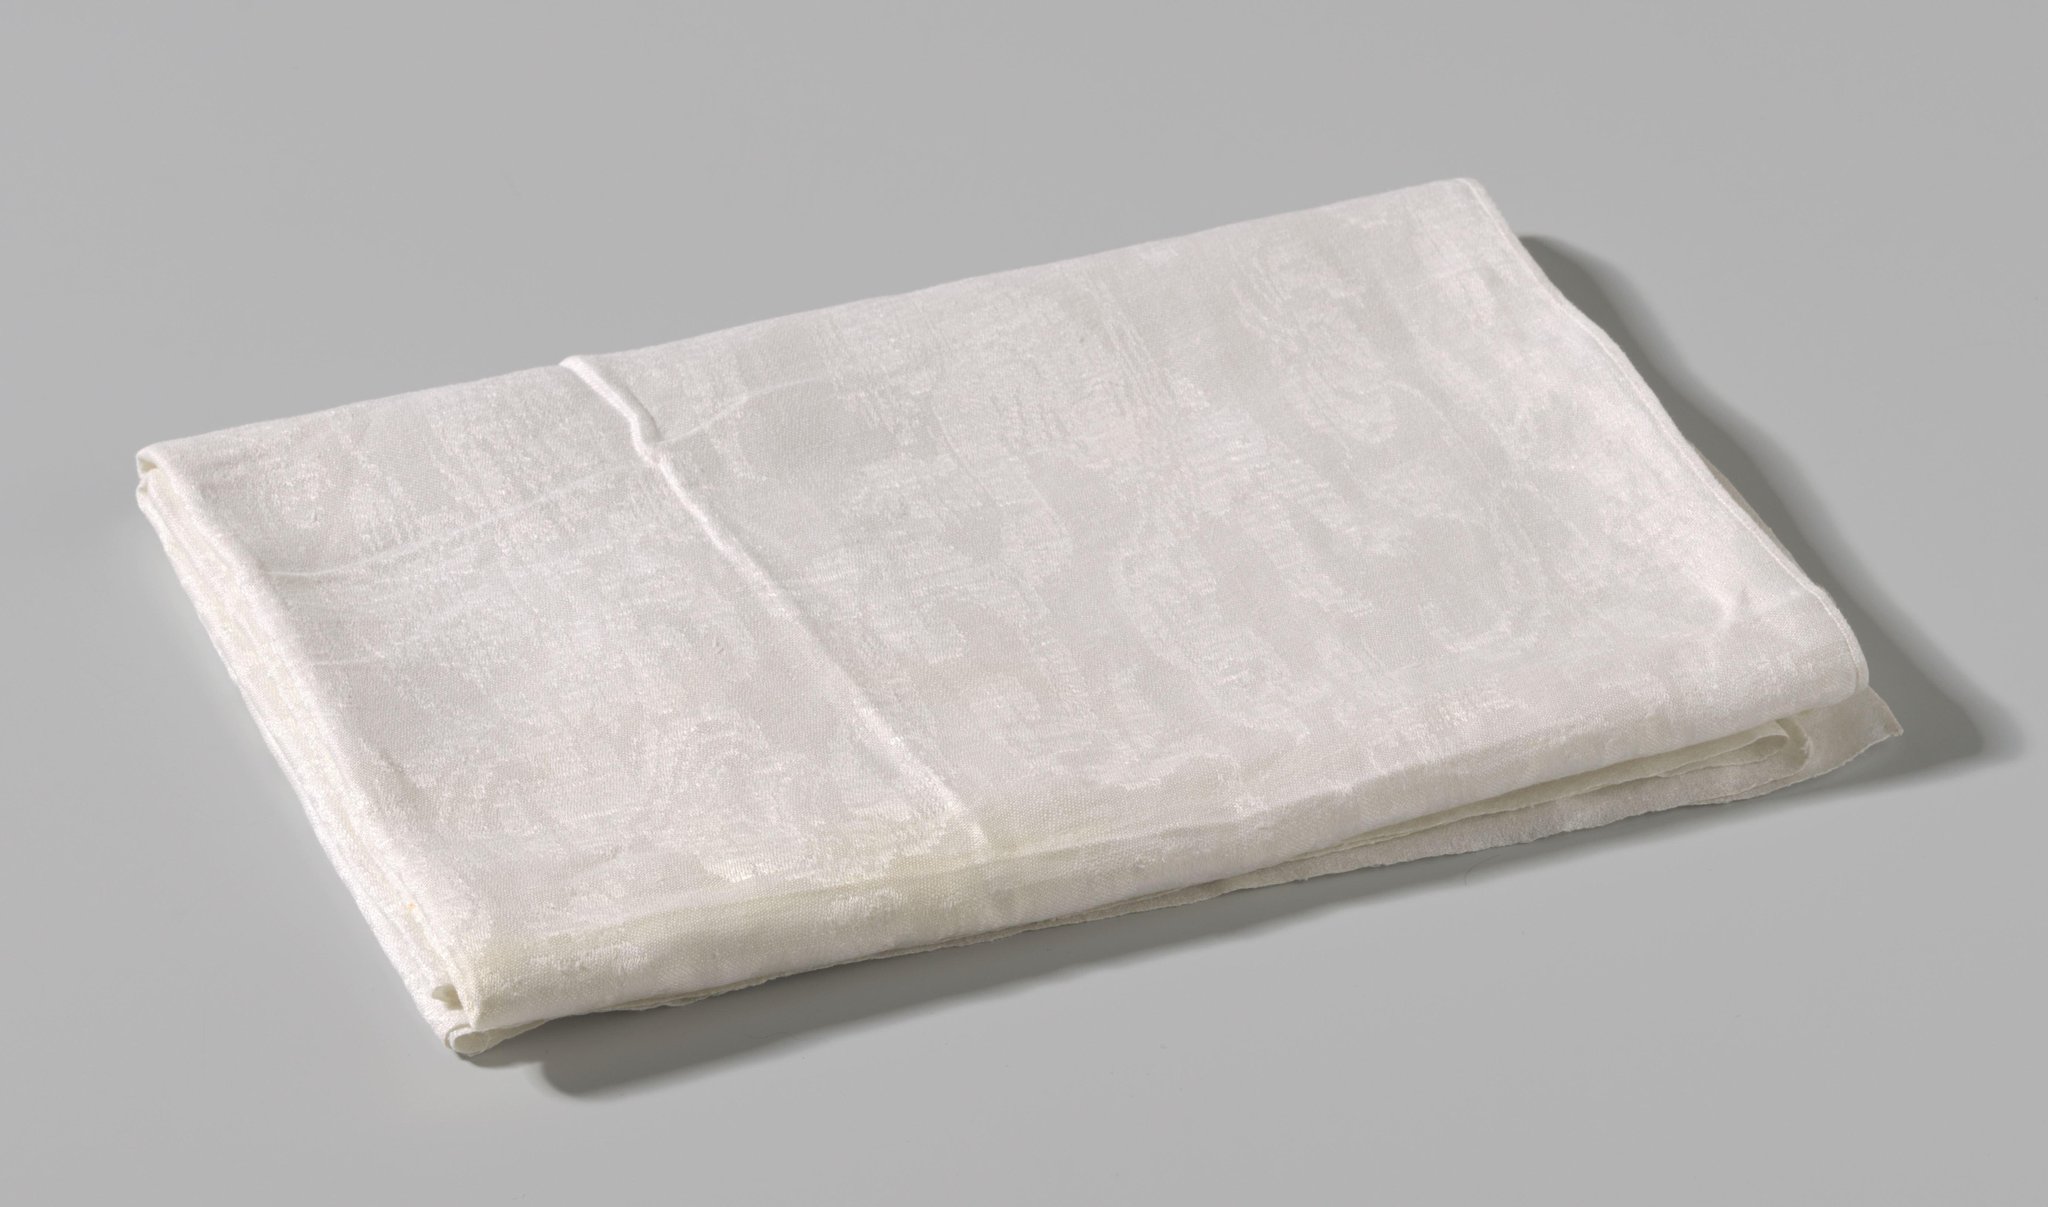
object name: napkin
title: Servet van linnendamast met putti en bloemen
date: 1660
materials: linen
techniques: damask, weave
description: Servet van linnendamast. Het patroon heeft bloemen en vruchten waartussen putti die hoorns des overvloed dragen en putti die een bloemenmand dragen. De lopende rand heeft een golvende lijn waartussen vogels en bloemen en een blokrand. Het servet is stukgoed, waardoor het geen liggende randen en hoeken heeft. Het servet hoort bij een tafellaken (BK-KOG-2607-A).